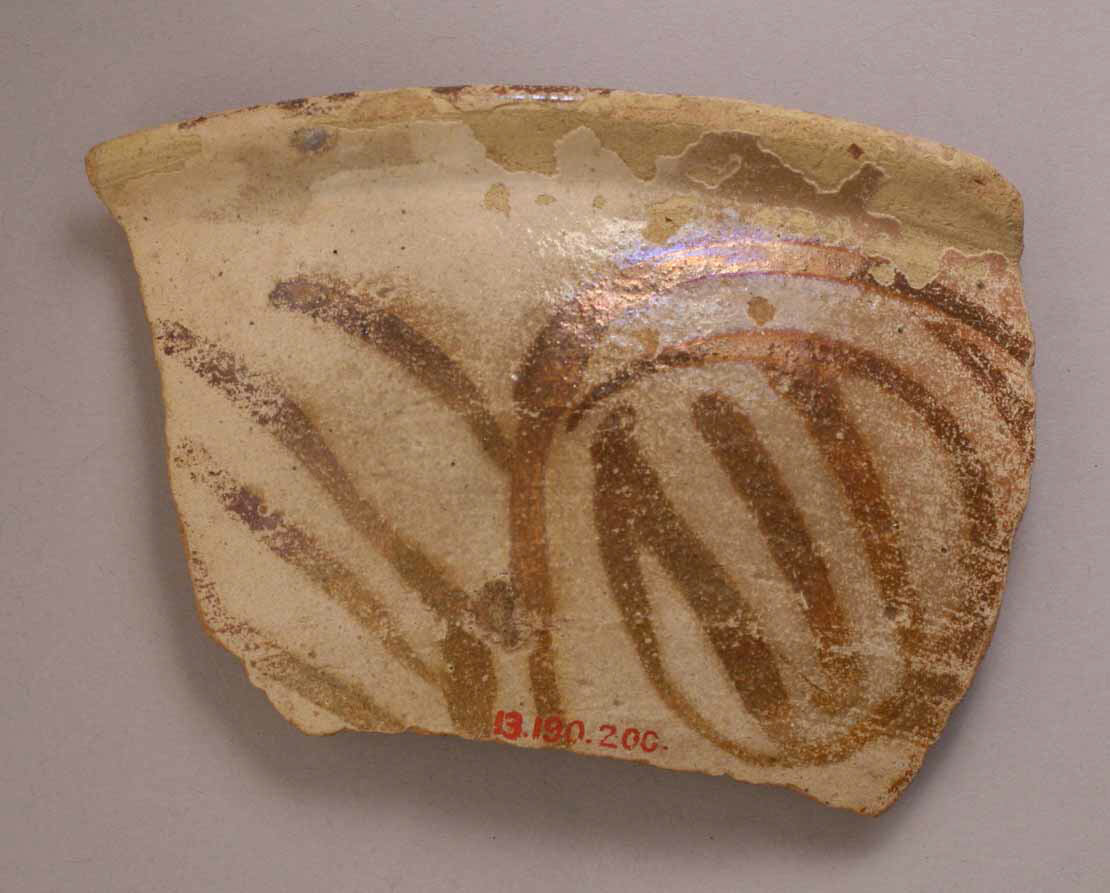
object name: ceramic fragment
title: Fragment of a Dish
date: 1001-1200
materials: earthenware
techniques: luster painting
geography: egypt